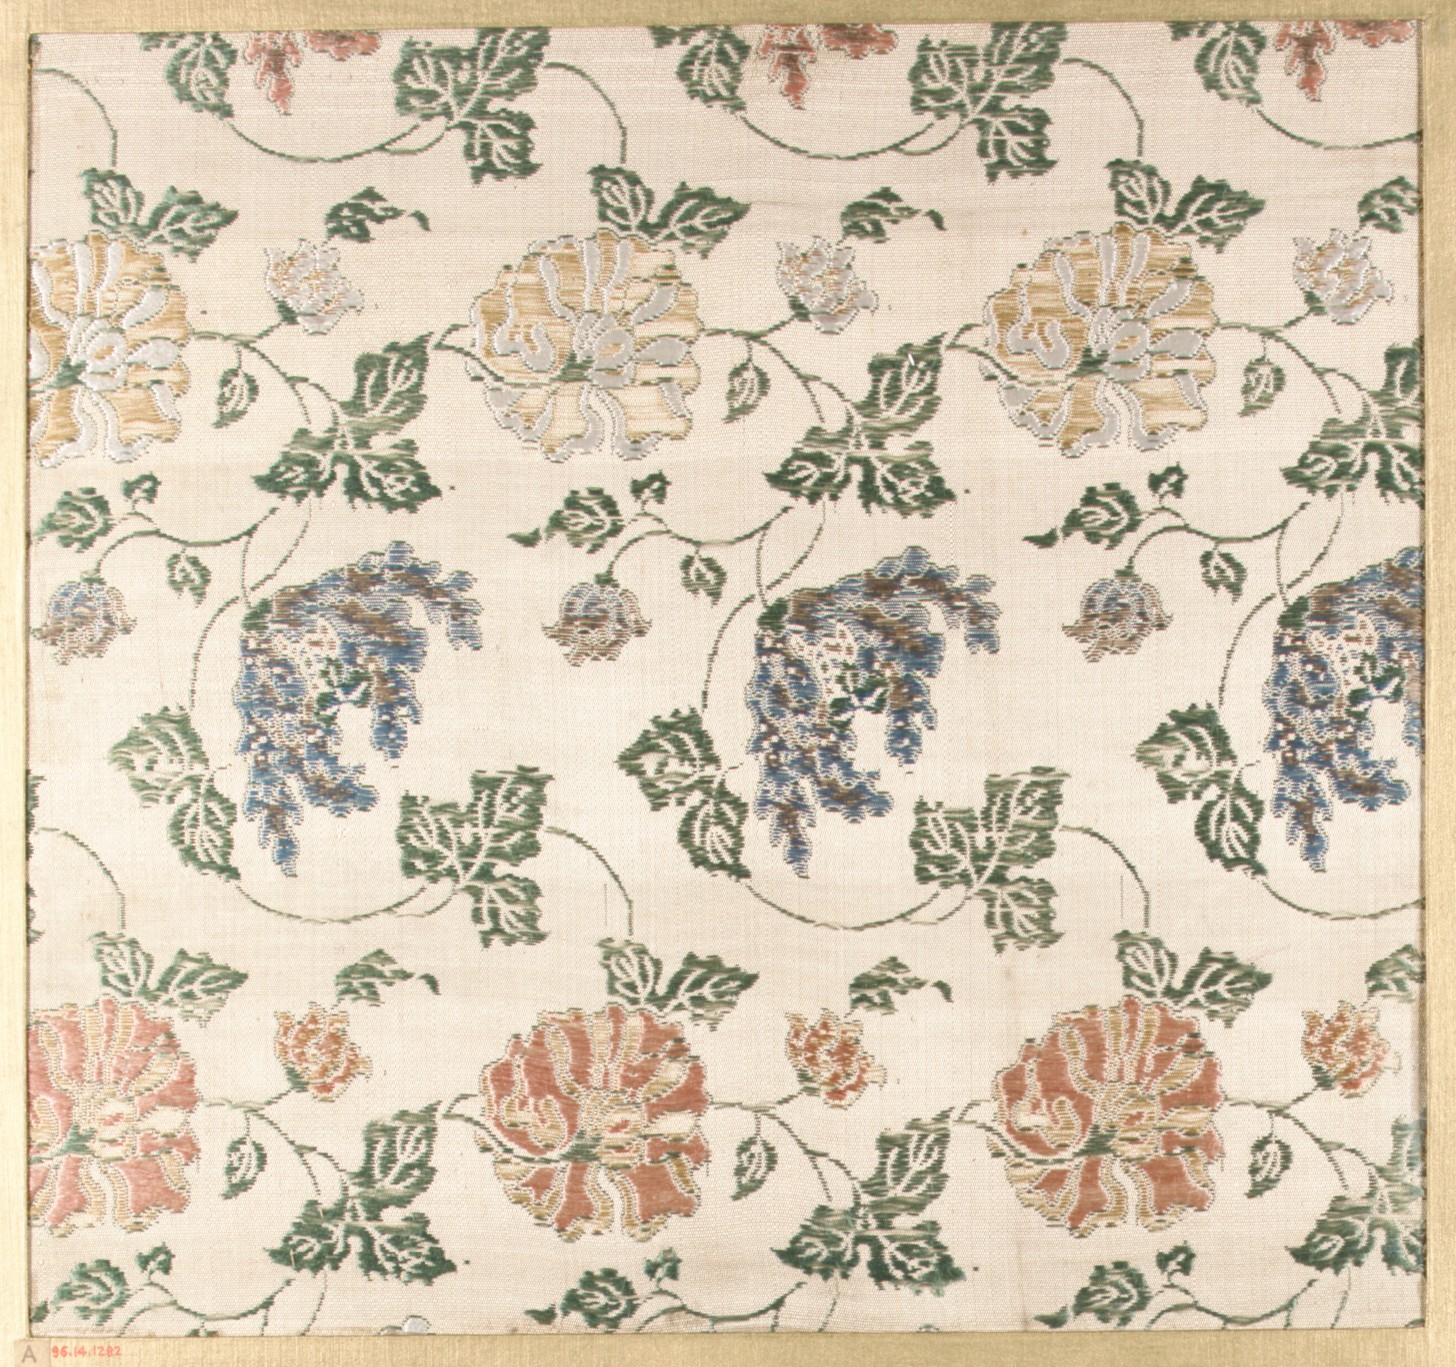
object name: piece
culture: japanese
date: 1701-1900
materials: silk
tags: leaves